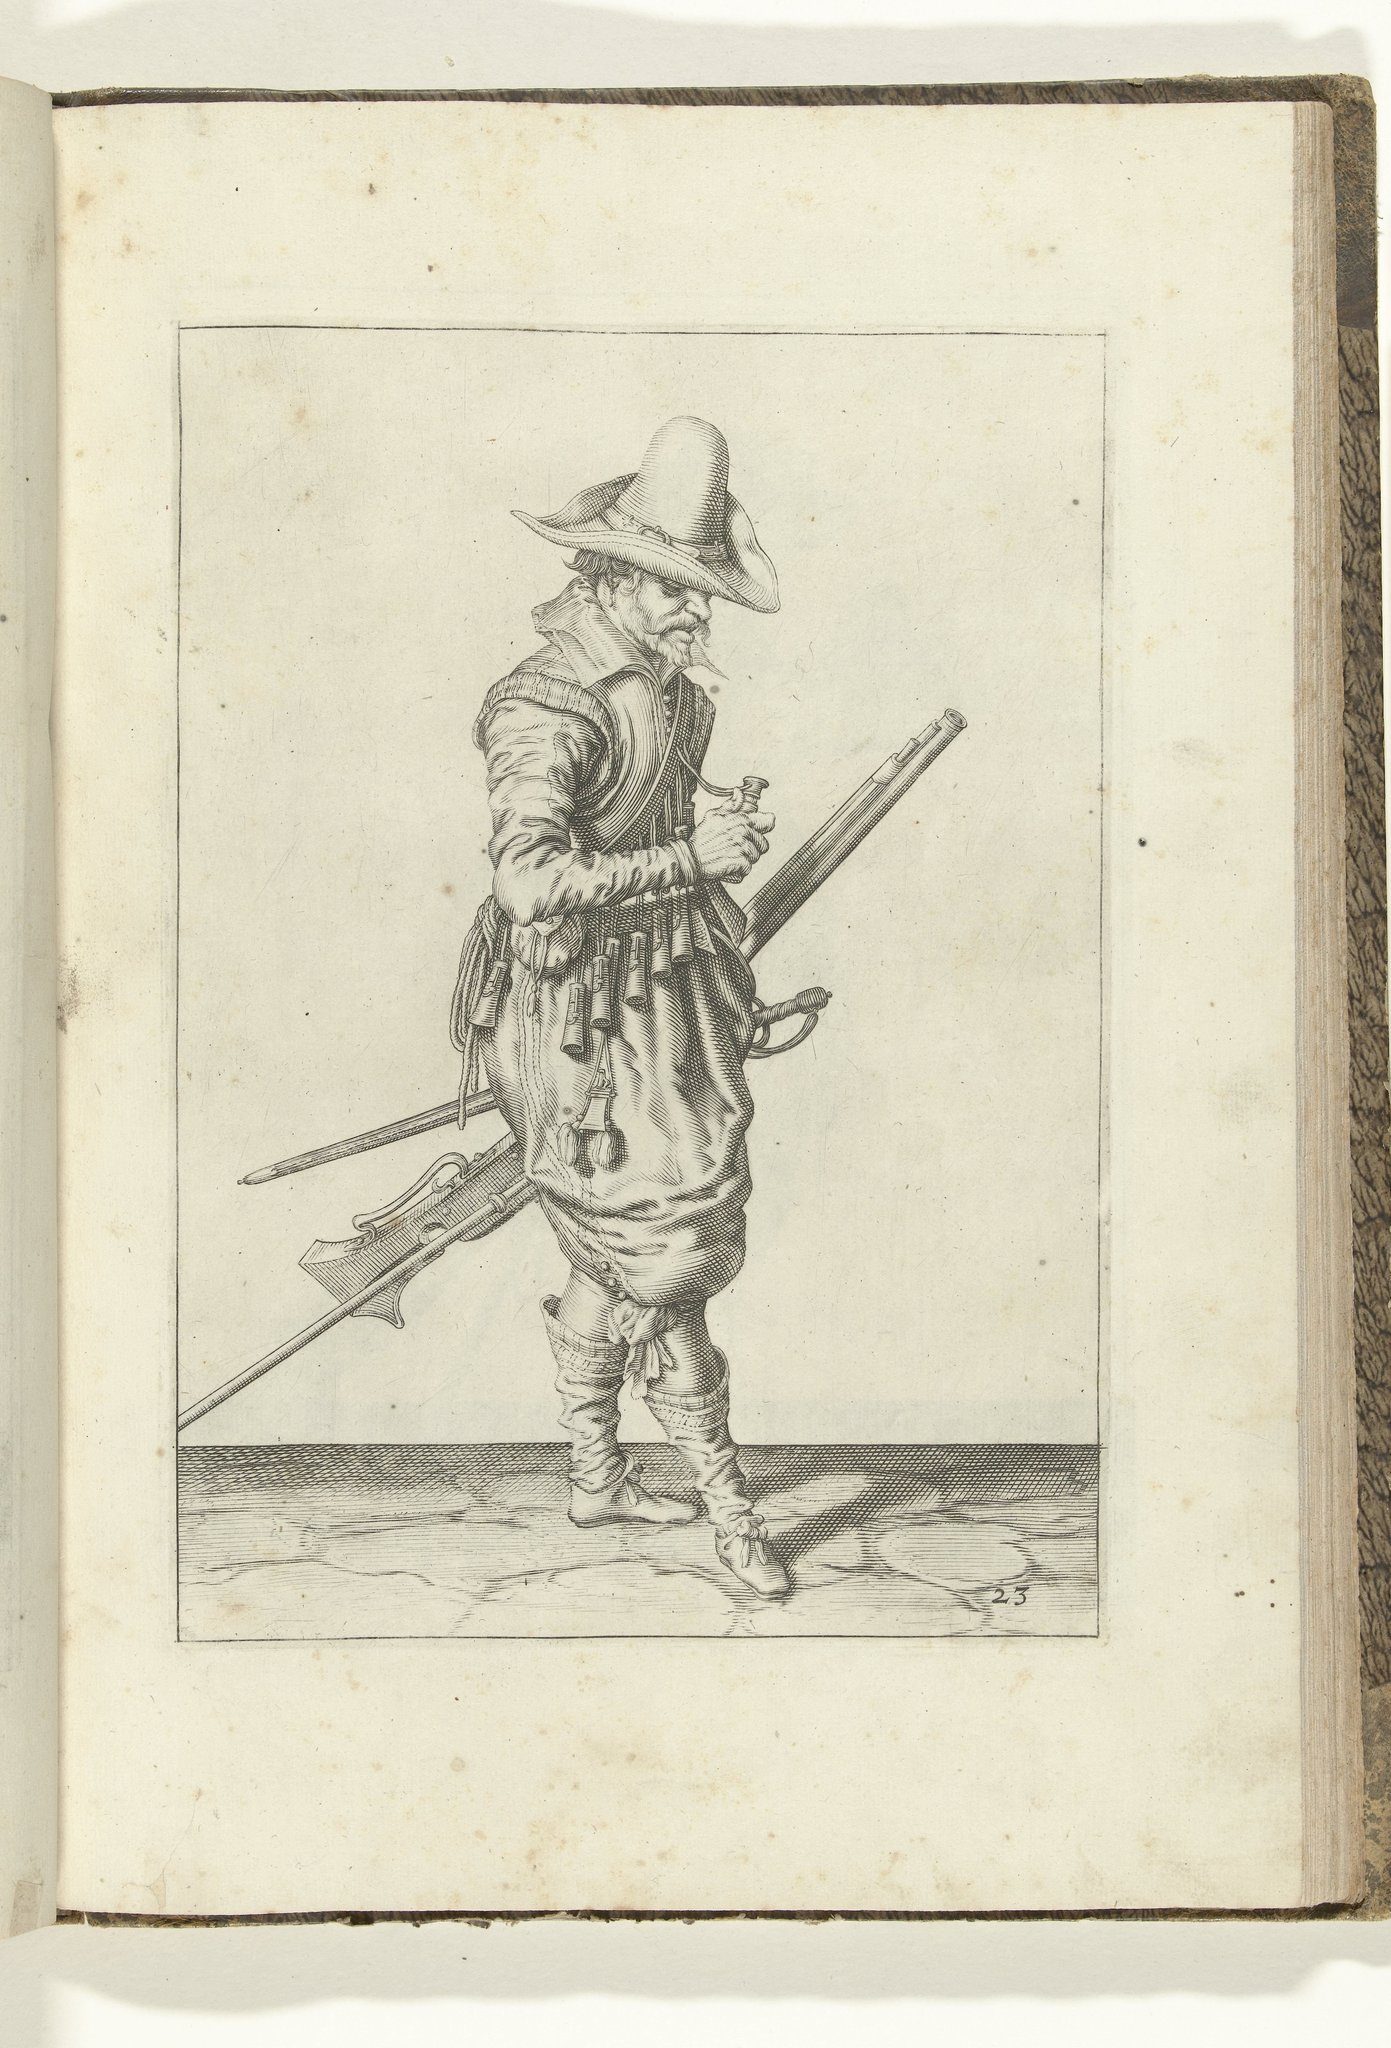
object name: print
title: Soldaat met een musket die een kruitmaat opent (nr. 23), ca. 1600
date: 1597-1608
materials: paper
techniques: engraving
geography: amsterdam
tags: maurice (prince of orange), handling of weapons ~ military training, weapons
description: Een soldaat, ten voeten uit, naar rechts, die met zijn linkerhand bij zijn linkerdijbeen een musket (een bepaald type vuurwapen) vasthoudt, de loop schuin omhoog wijzend (nr. 23), ca. 1600. In zijn linkerhand behalve het musket ook een furket (musketvork). Met zijn rechterhand opent hij een van de kruitmaatjes aan zijn bandelier. Plaat 23 in de instructies voor het hanteren van het musket: Brief enseignement, sur les pourtraitz figurez, touchant le droit maniement du Mousquet. Onderdeel van de illustraties in een Franse editie van J. de Gheyns Wapenhandelinghe: J. de Gheyn, Maniement d'armes, d'arquebuses, mousquetz et piques : en conformité de l'ordre de Mour le Prince Maurice, Prince d'Orange, Amsterdam 1608. Krijgswezen rond 1600.